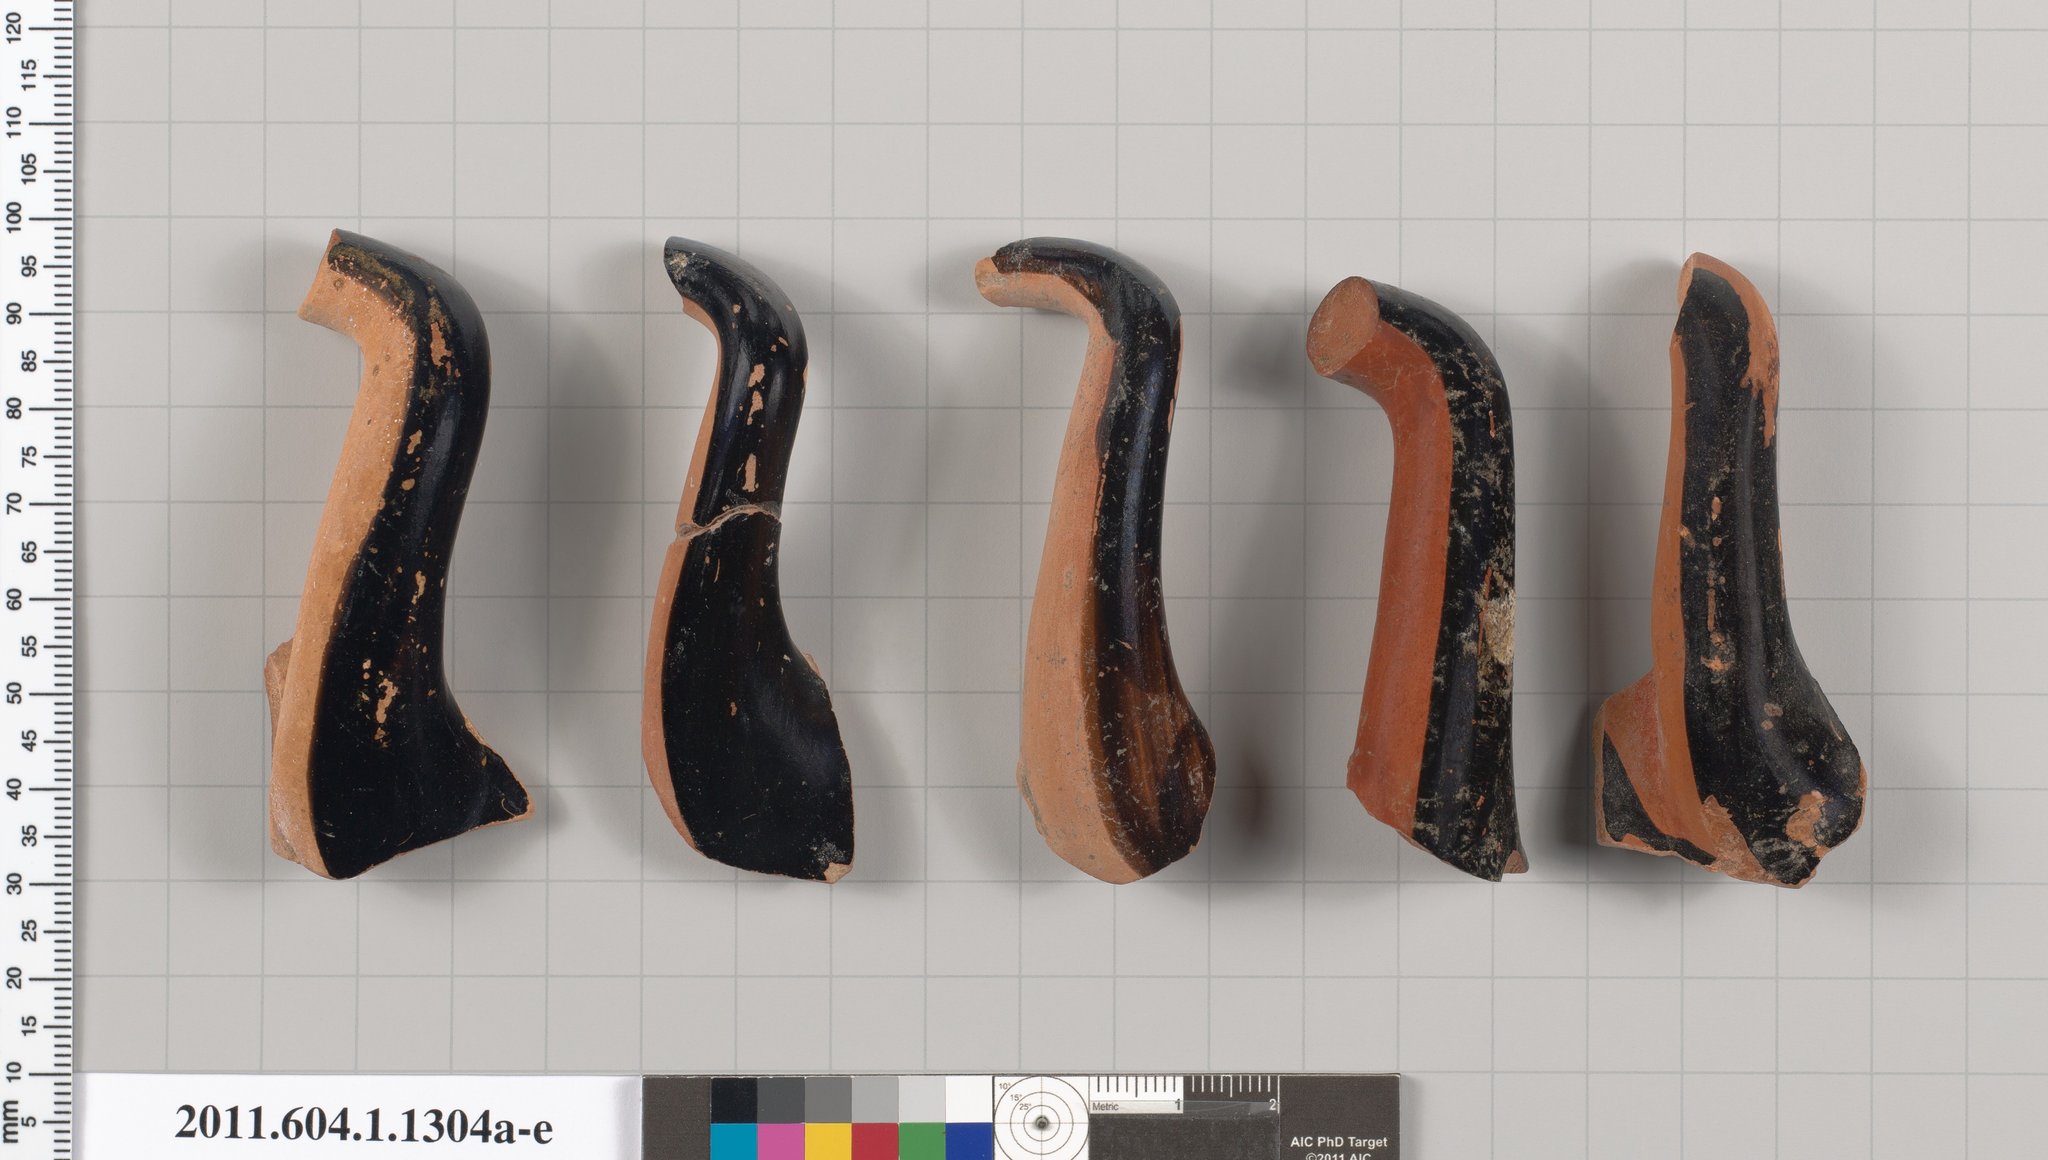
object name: kylix fragment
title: Terracotta fragments of kylikes (drinking cups)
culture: greek, attic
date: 500-401 BCE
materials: terracotta